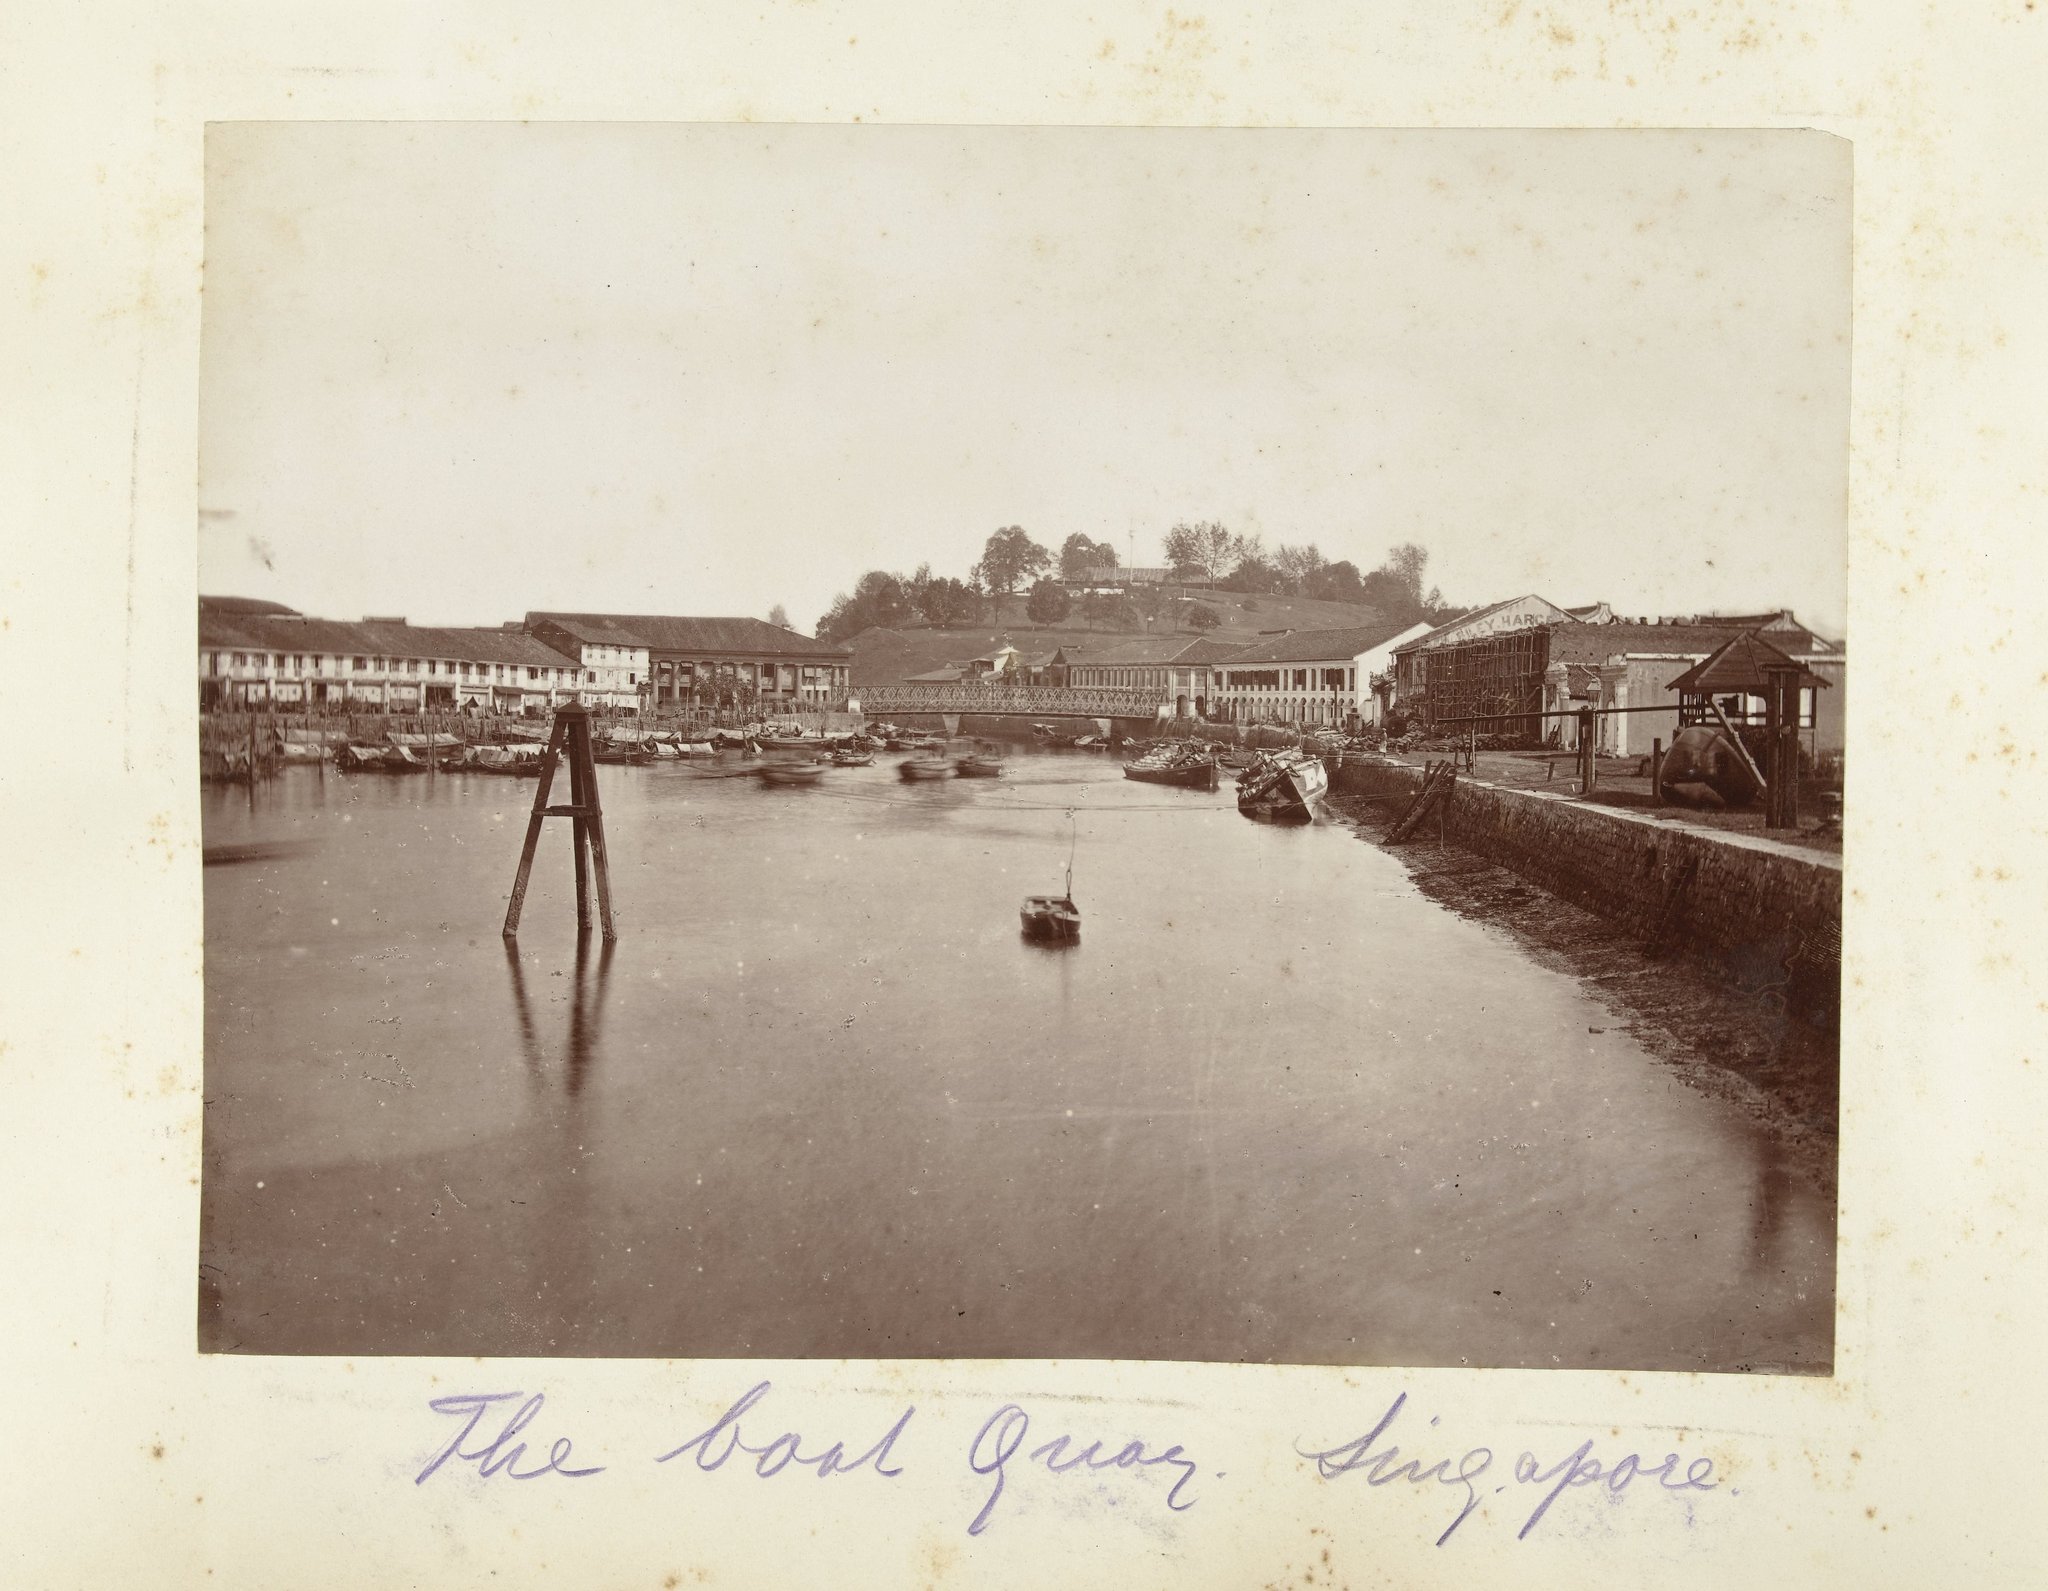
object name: photograph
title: Binnenhaven van Singapore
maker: Anonymous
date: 1890-1910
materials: cardboard, paper, photographic support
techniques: gelatin silver print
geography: netherlands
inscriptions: caption: ‘The boat quay Singapore’